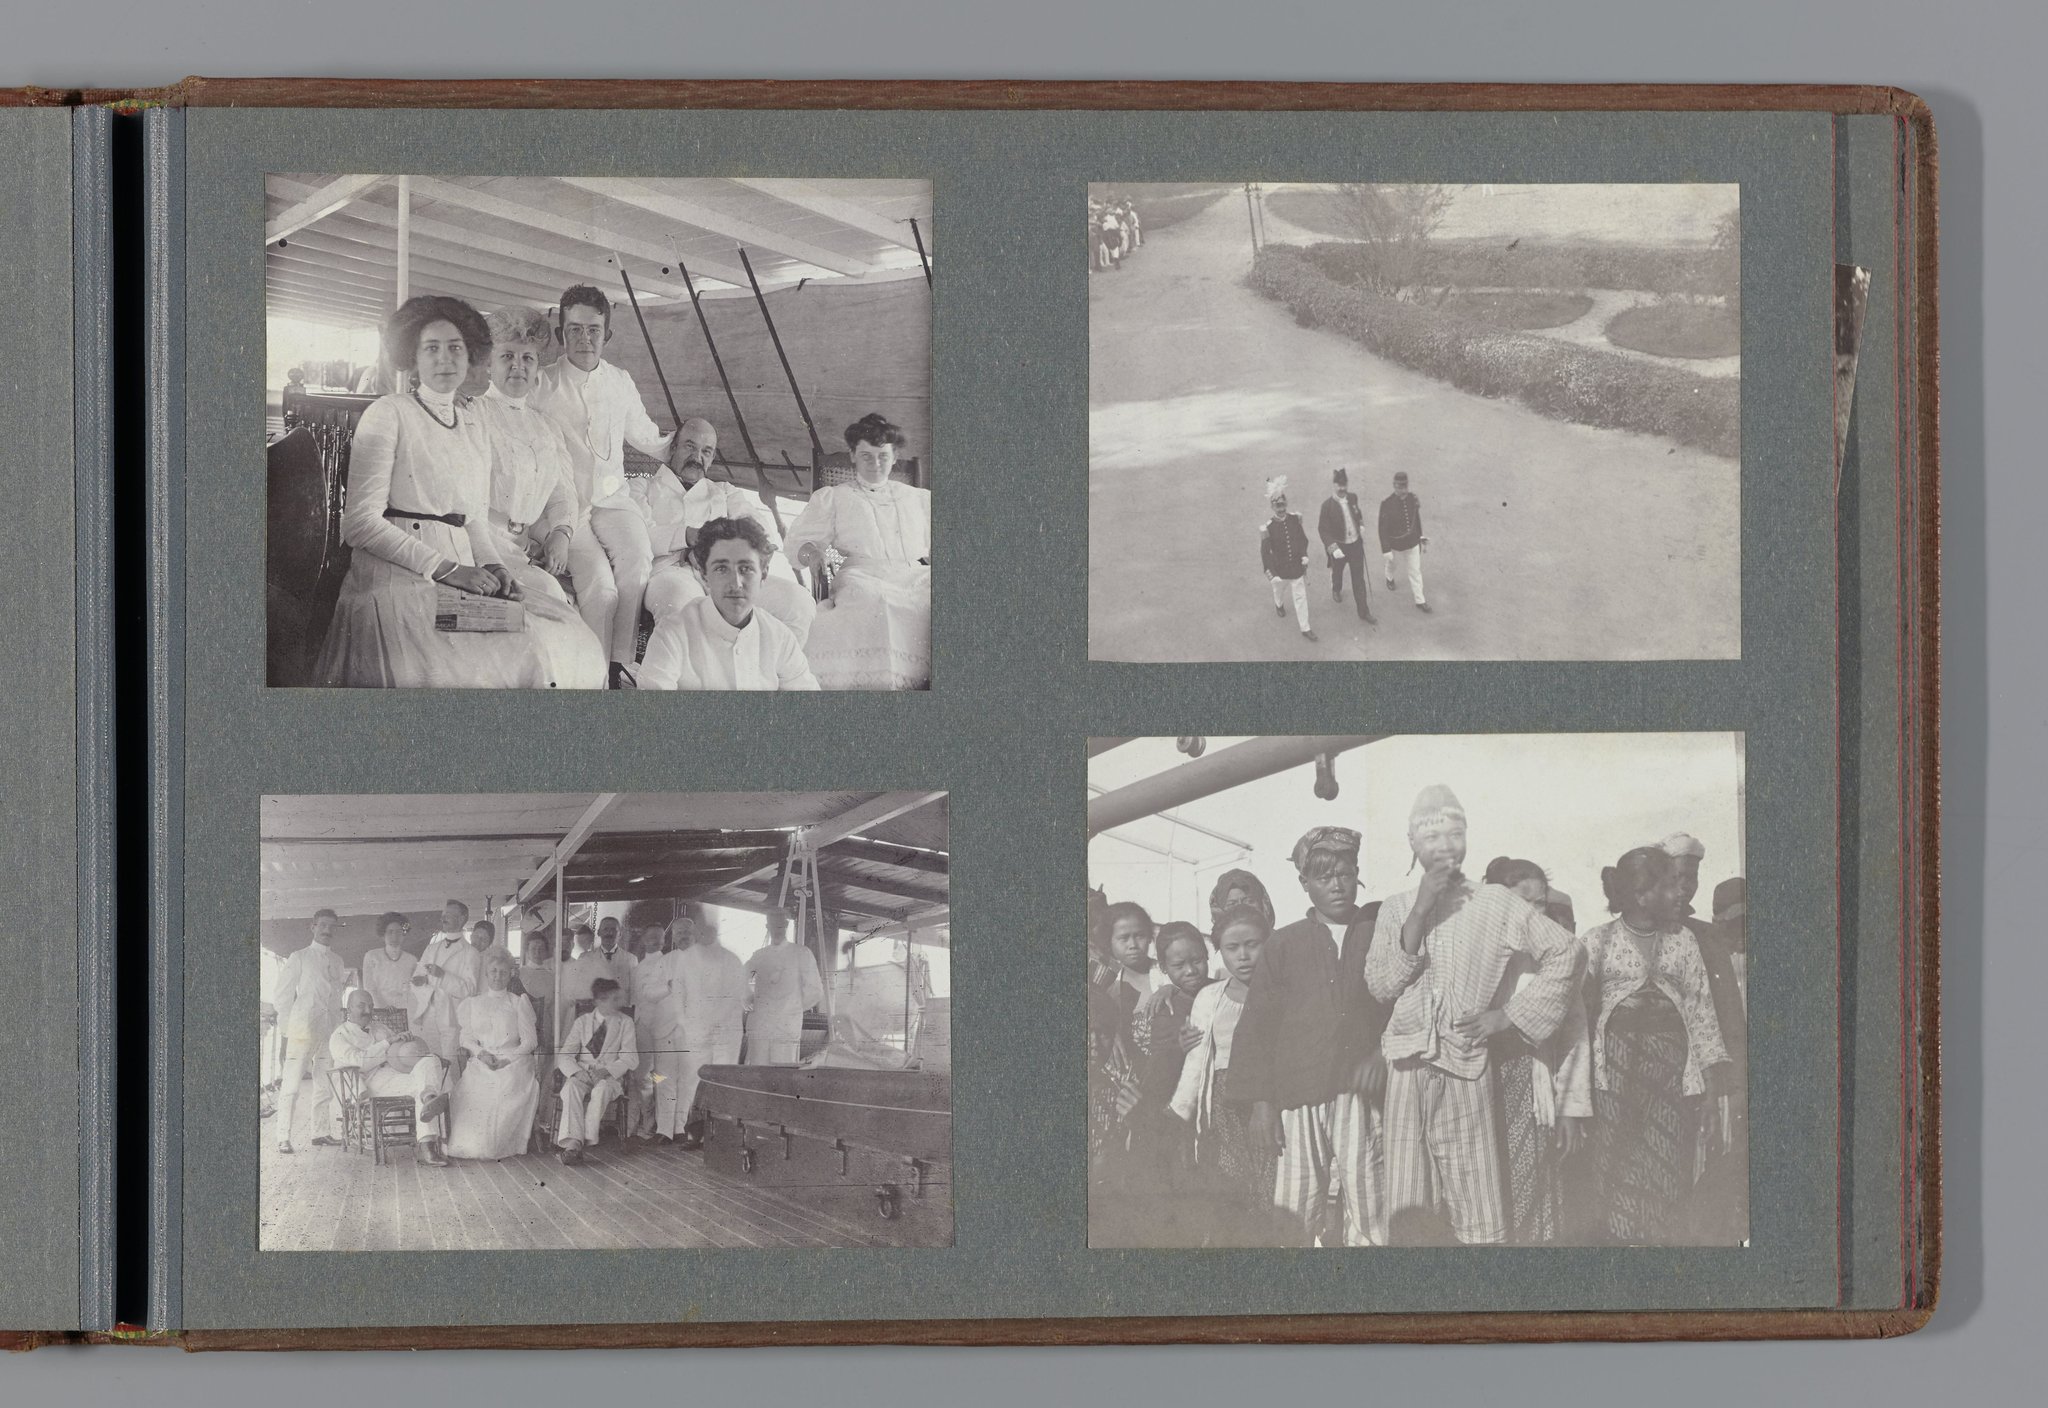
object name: photograph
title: Drie mannen in uniform, lopend over een breed pad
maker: Anonymous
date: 1905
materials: cardboard, paper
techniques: photography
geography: paramaribo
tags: suriname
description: Drie mannen in uniform, lopend over een breed pad. Onderdeel van fotoalbum 'Suriname'.